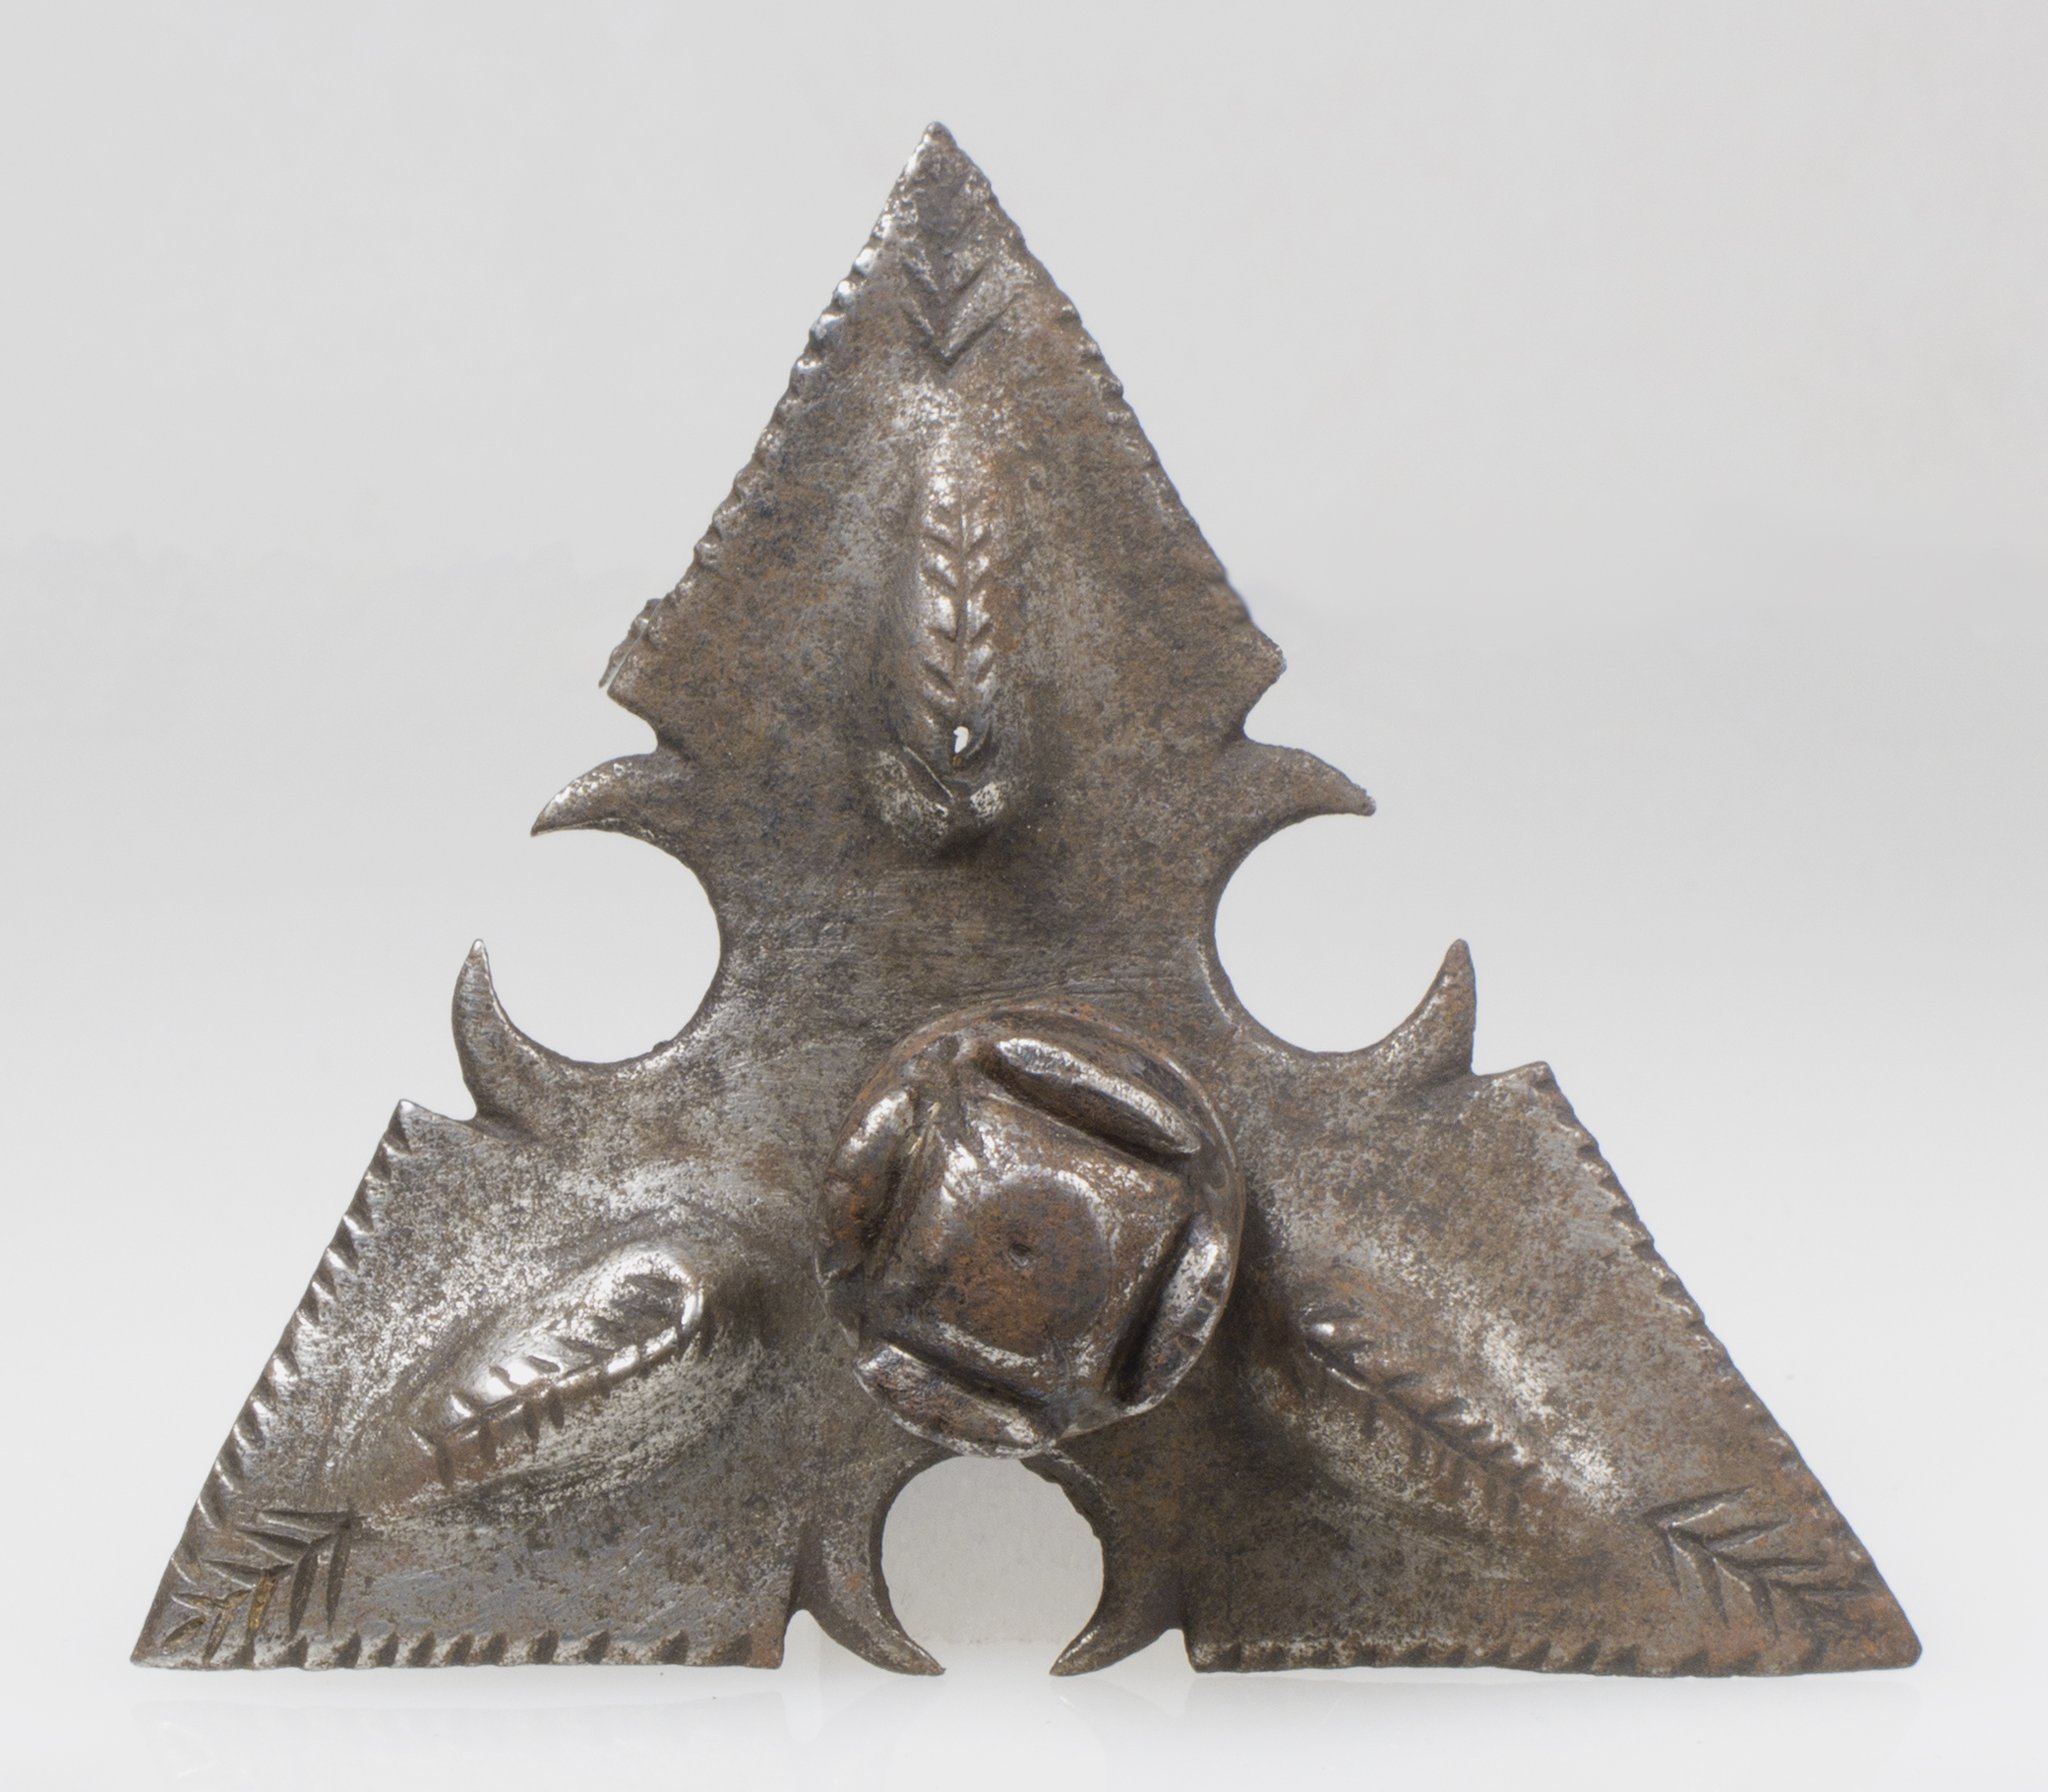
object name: plate and nail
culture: european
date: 1401-1600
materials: iron